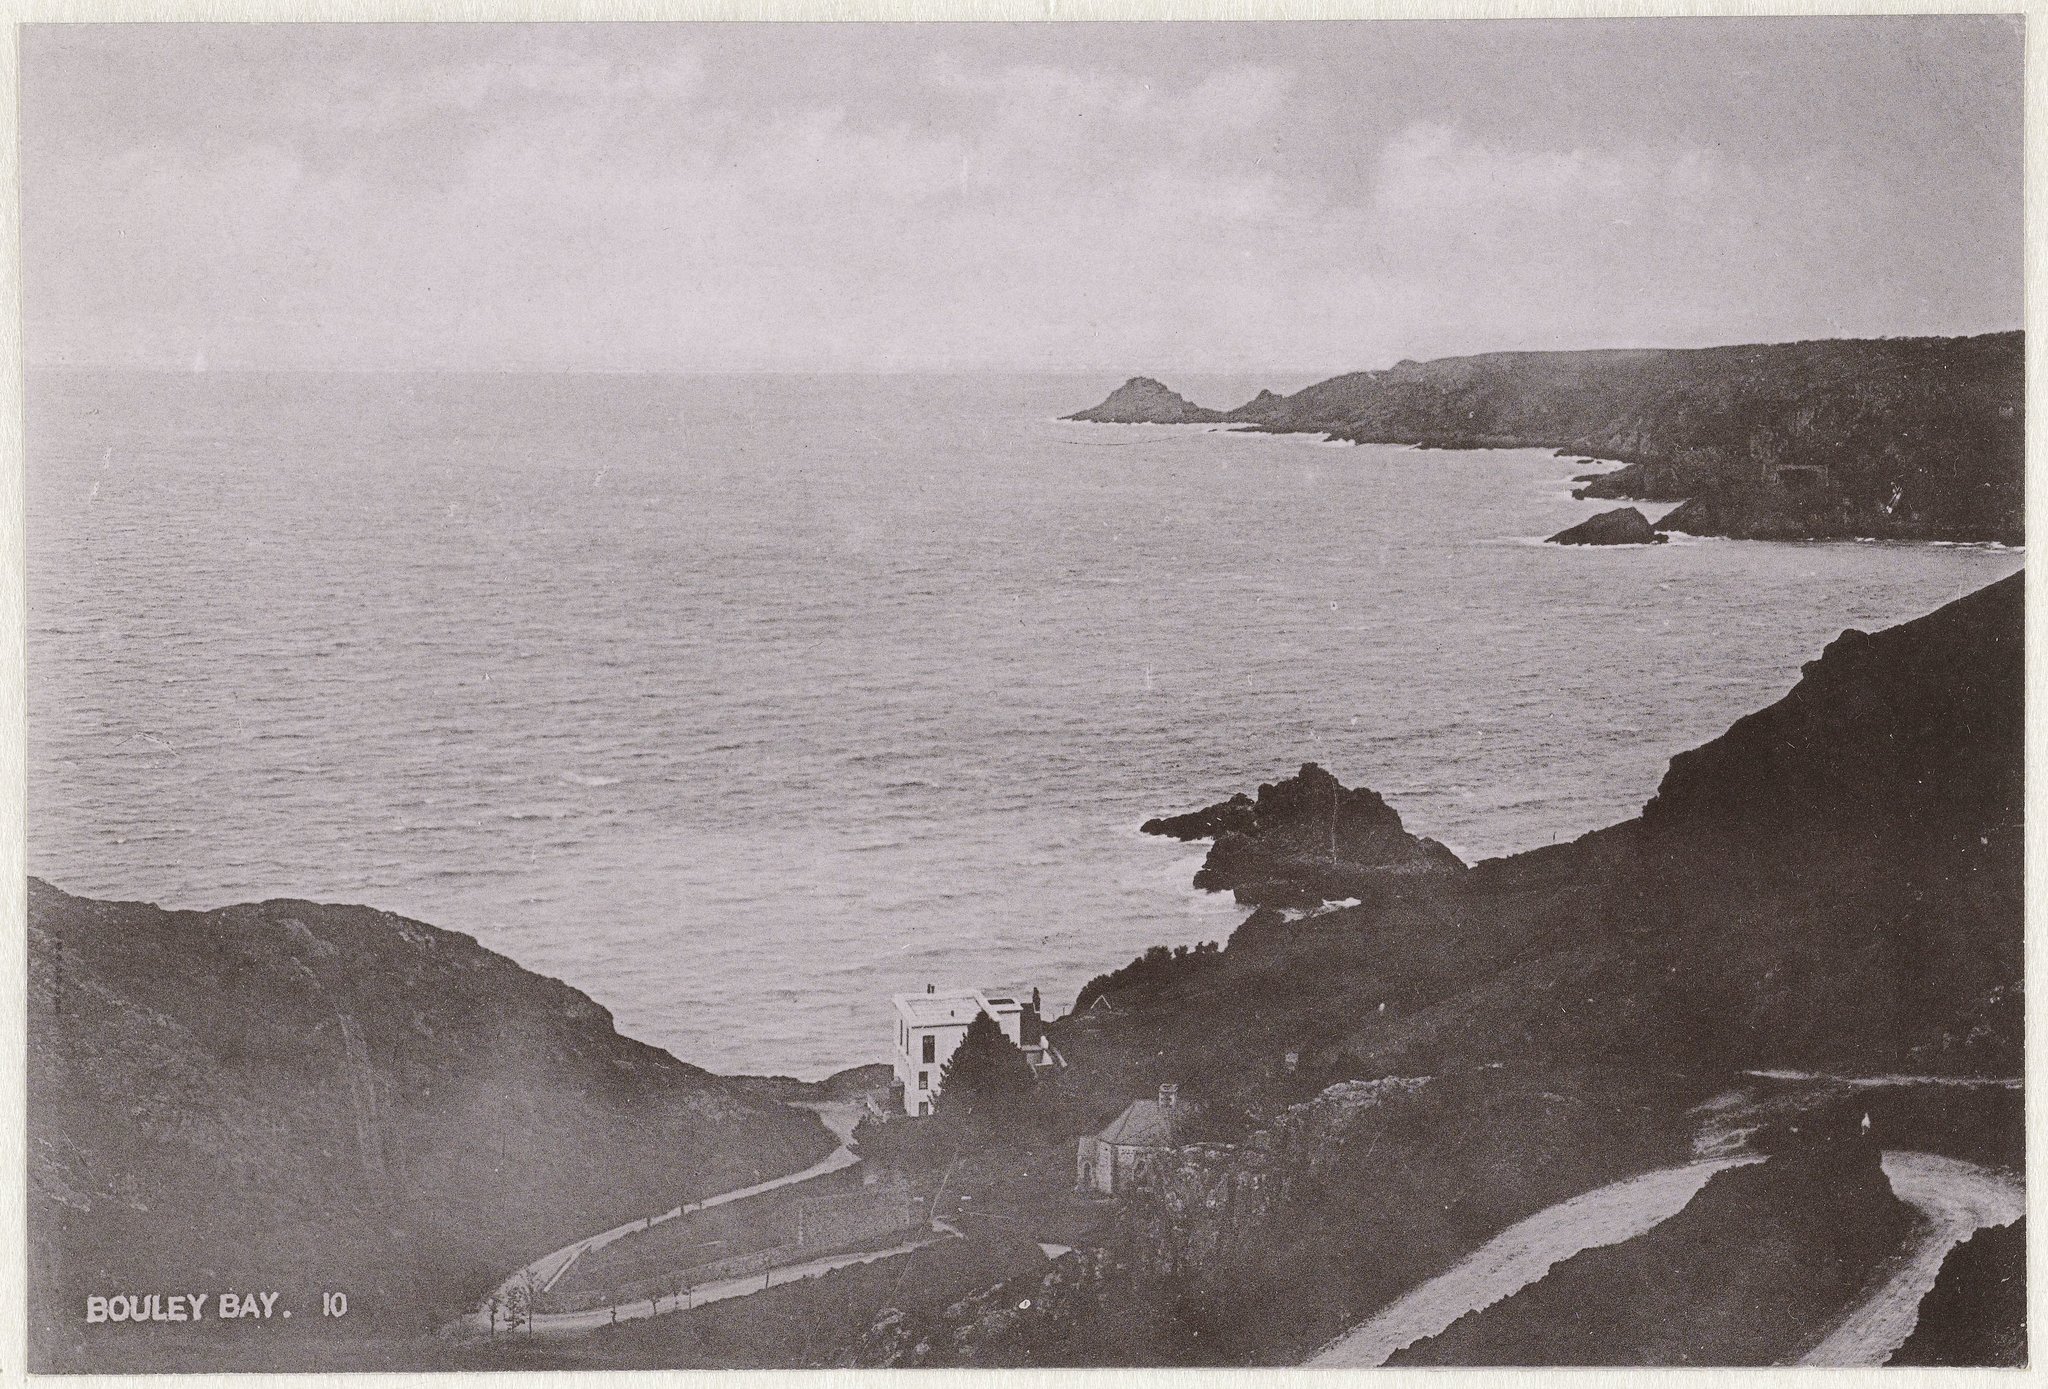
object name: photomechanical print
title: Bouley Bay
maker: Anonymous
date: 1870-1930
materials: paper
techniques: photograph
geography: jersey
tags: gulf, bay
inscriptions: number: ‘10’